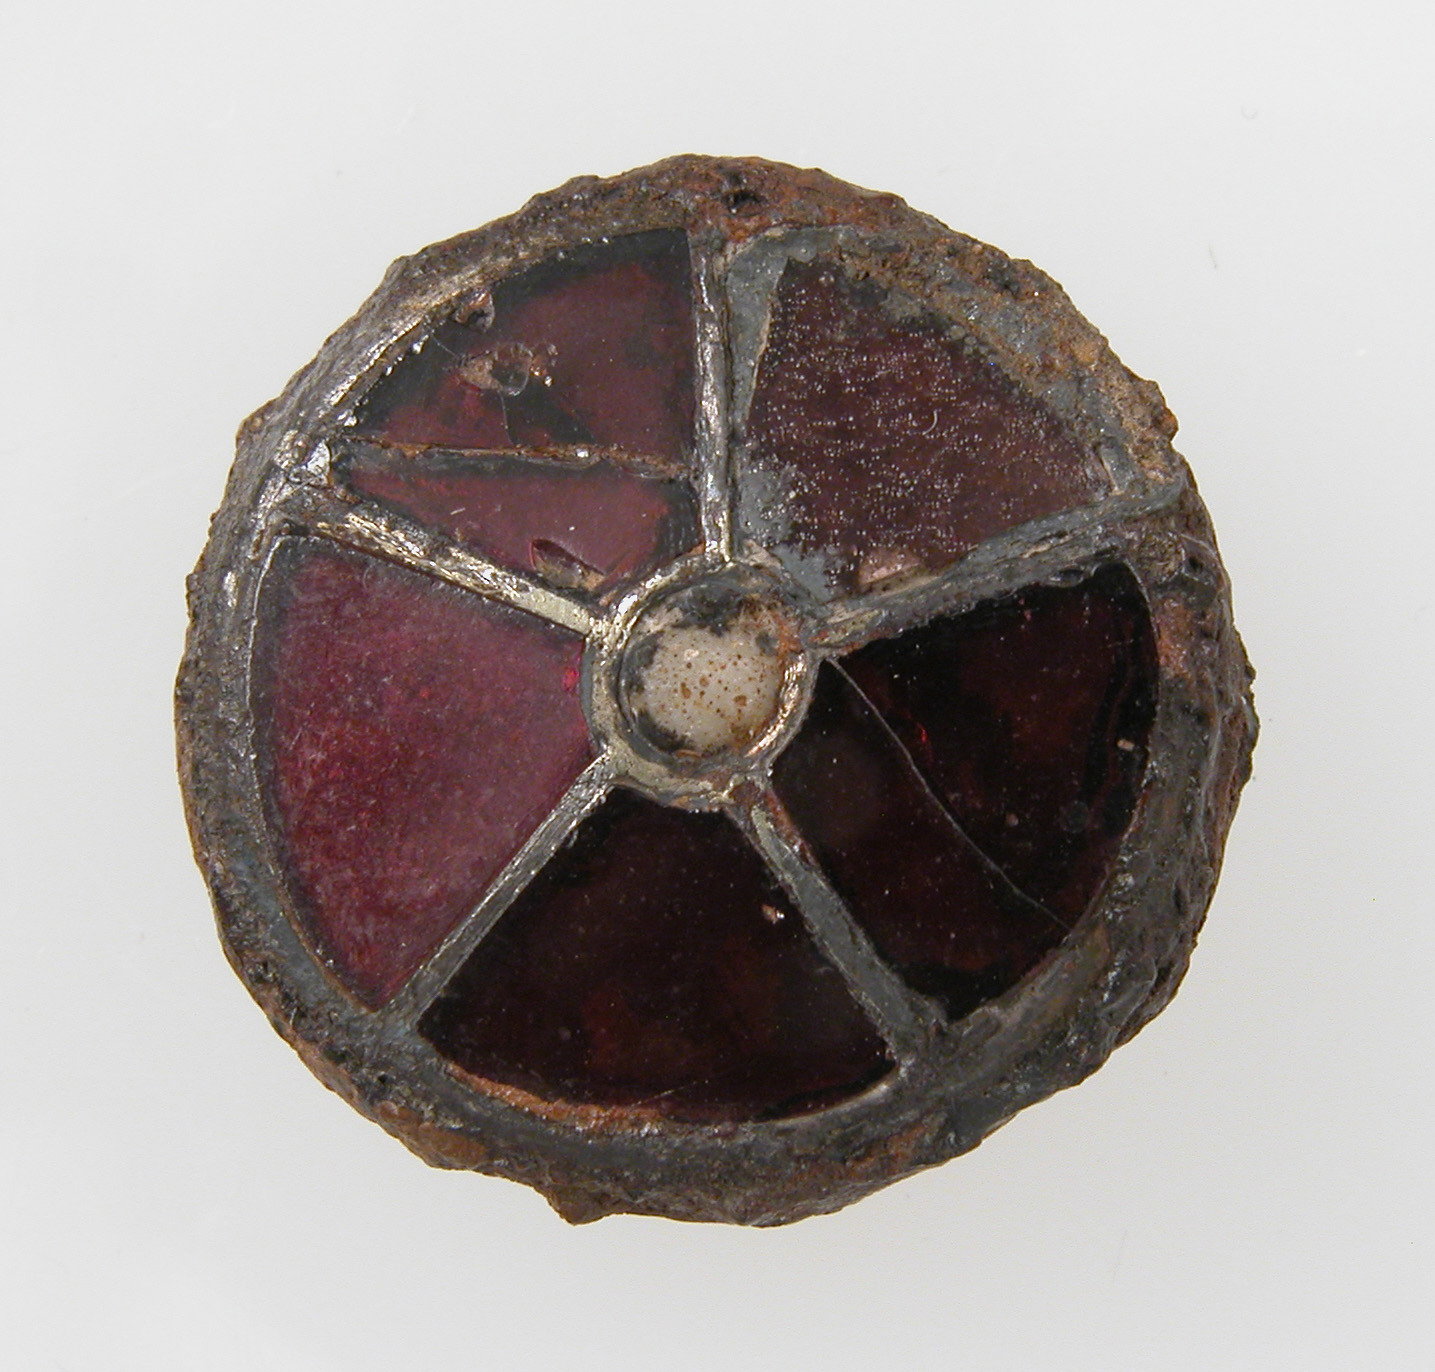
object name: brooch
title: Disk Brooch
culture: frankish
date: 501-600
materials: gemstone, glass, iron, paste, silver